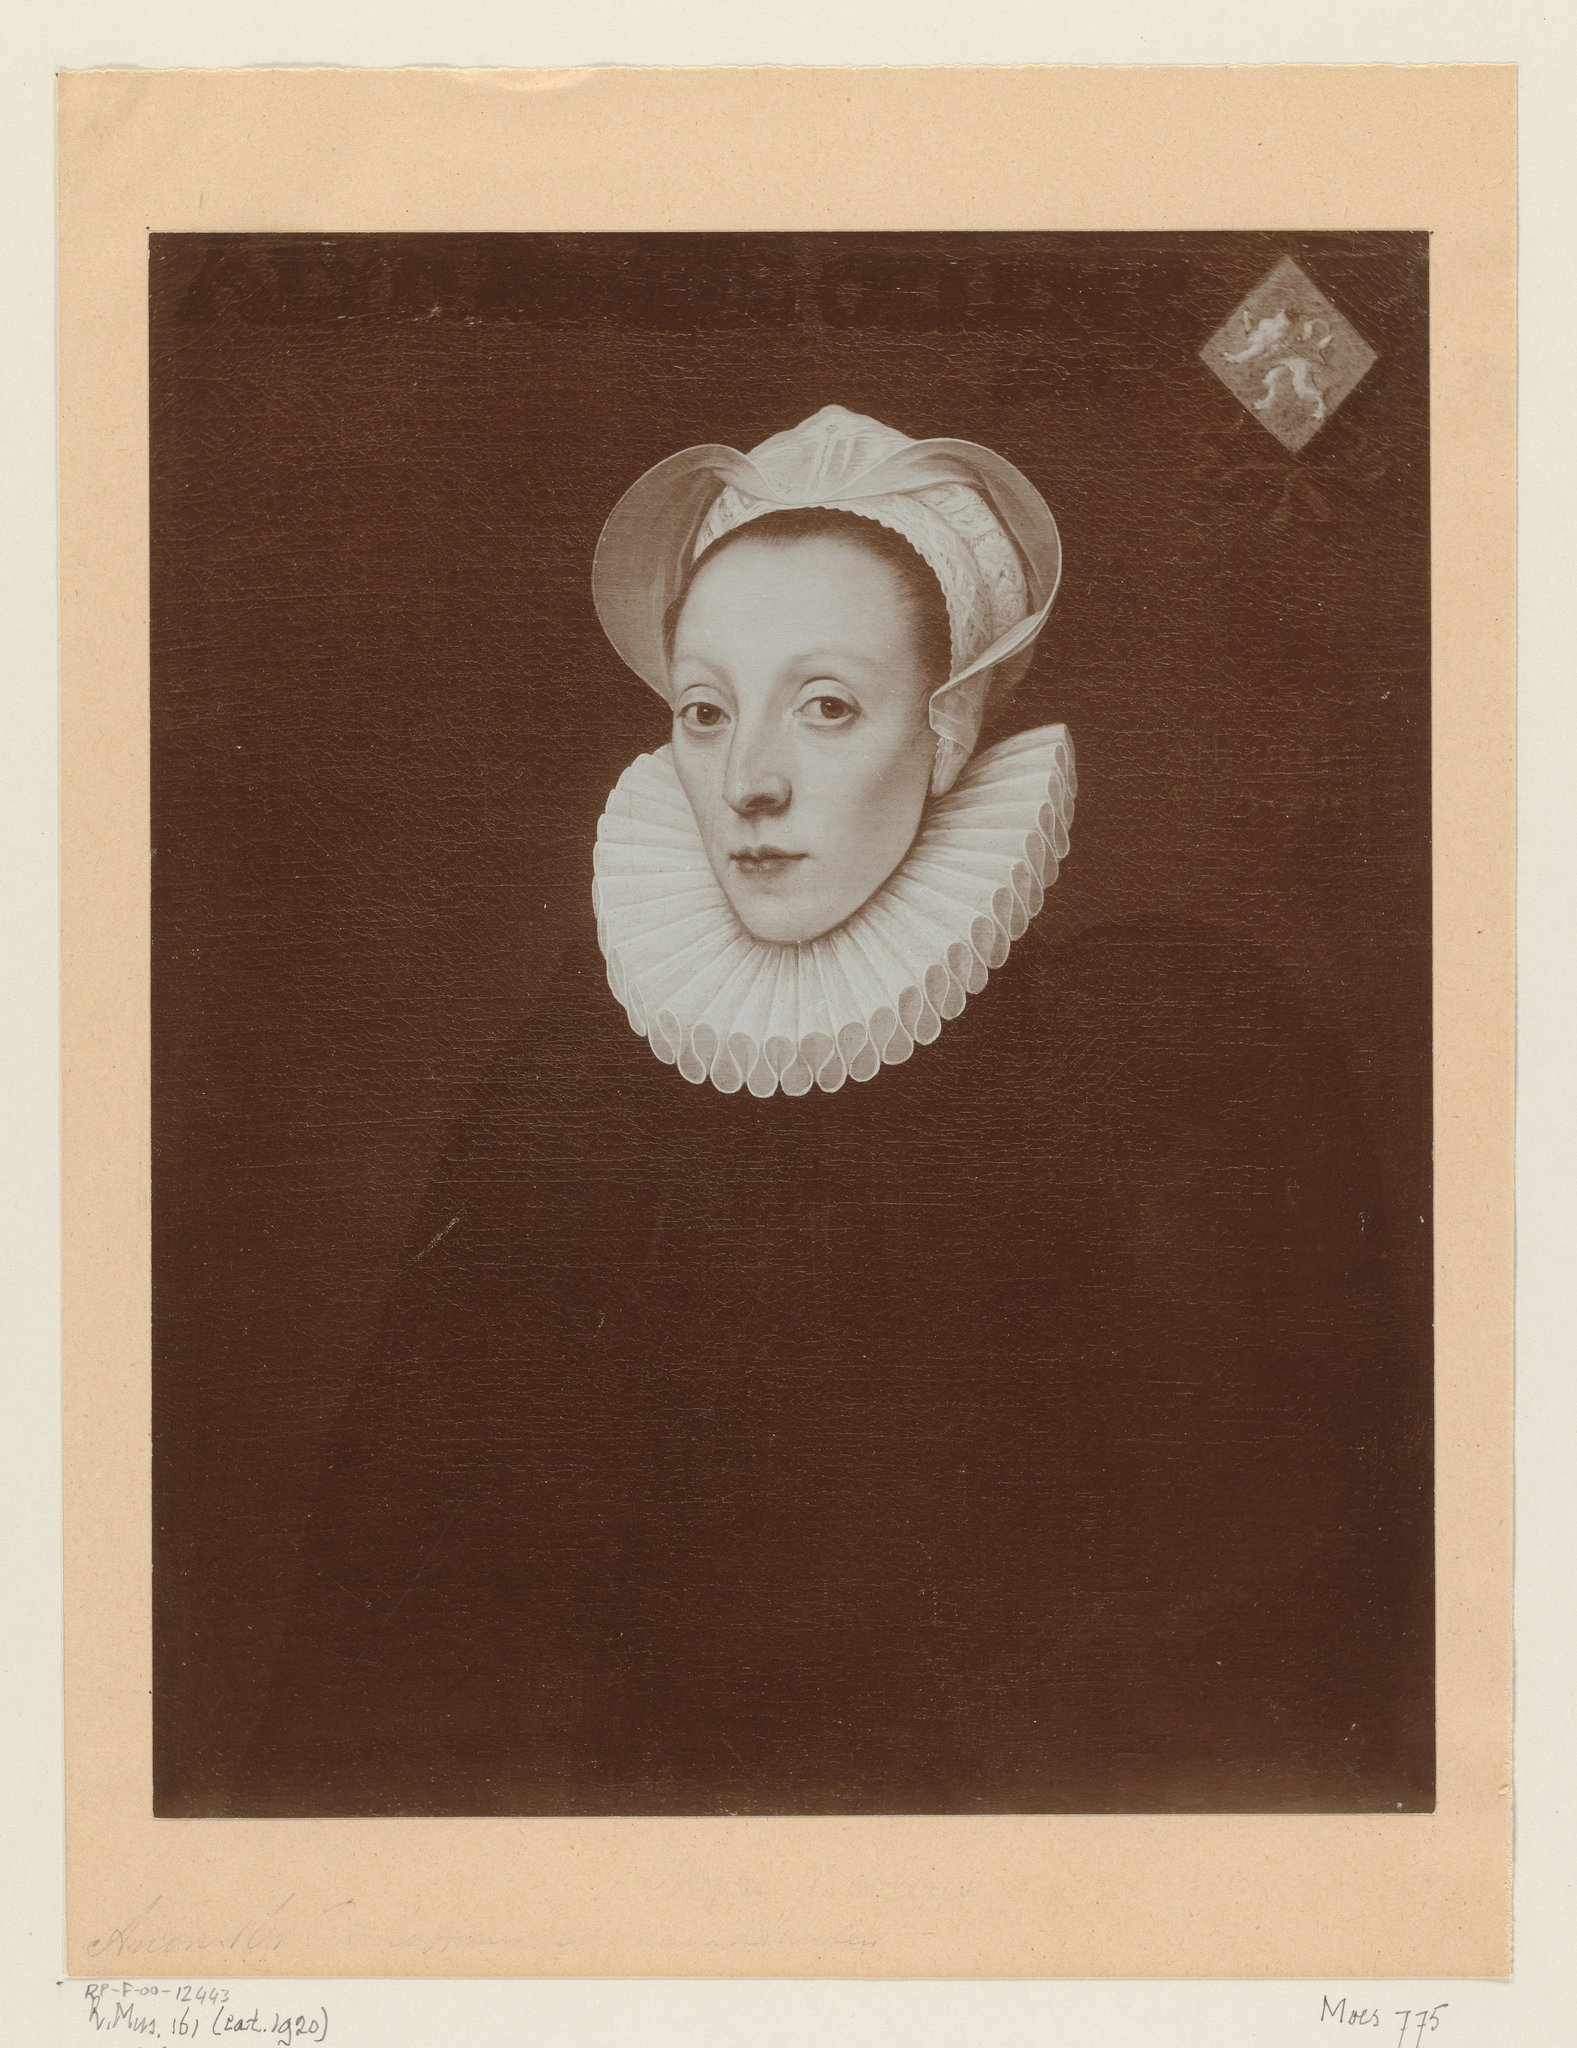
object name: reproduction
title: Fotoreproductie van een geschilderd portret van Alyda Boelens, echtgenote van Gerrit Bicker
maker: Anonymous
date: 1885-1910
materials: paper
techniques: collodion silver print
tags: historical persons - bb - woman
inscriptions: collector's mark: Lugt 2228